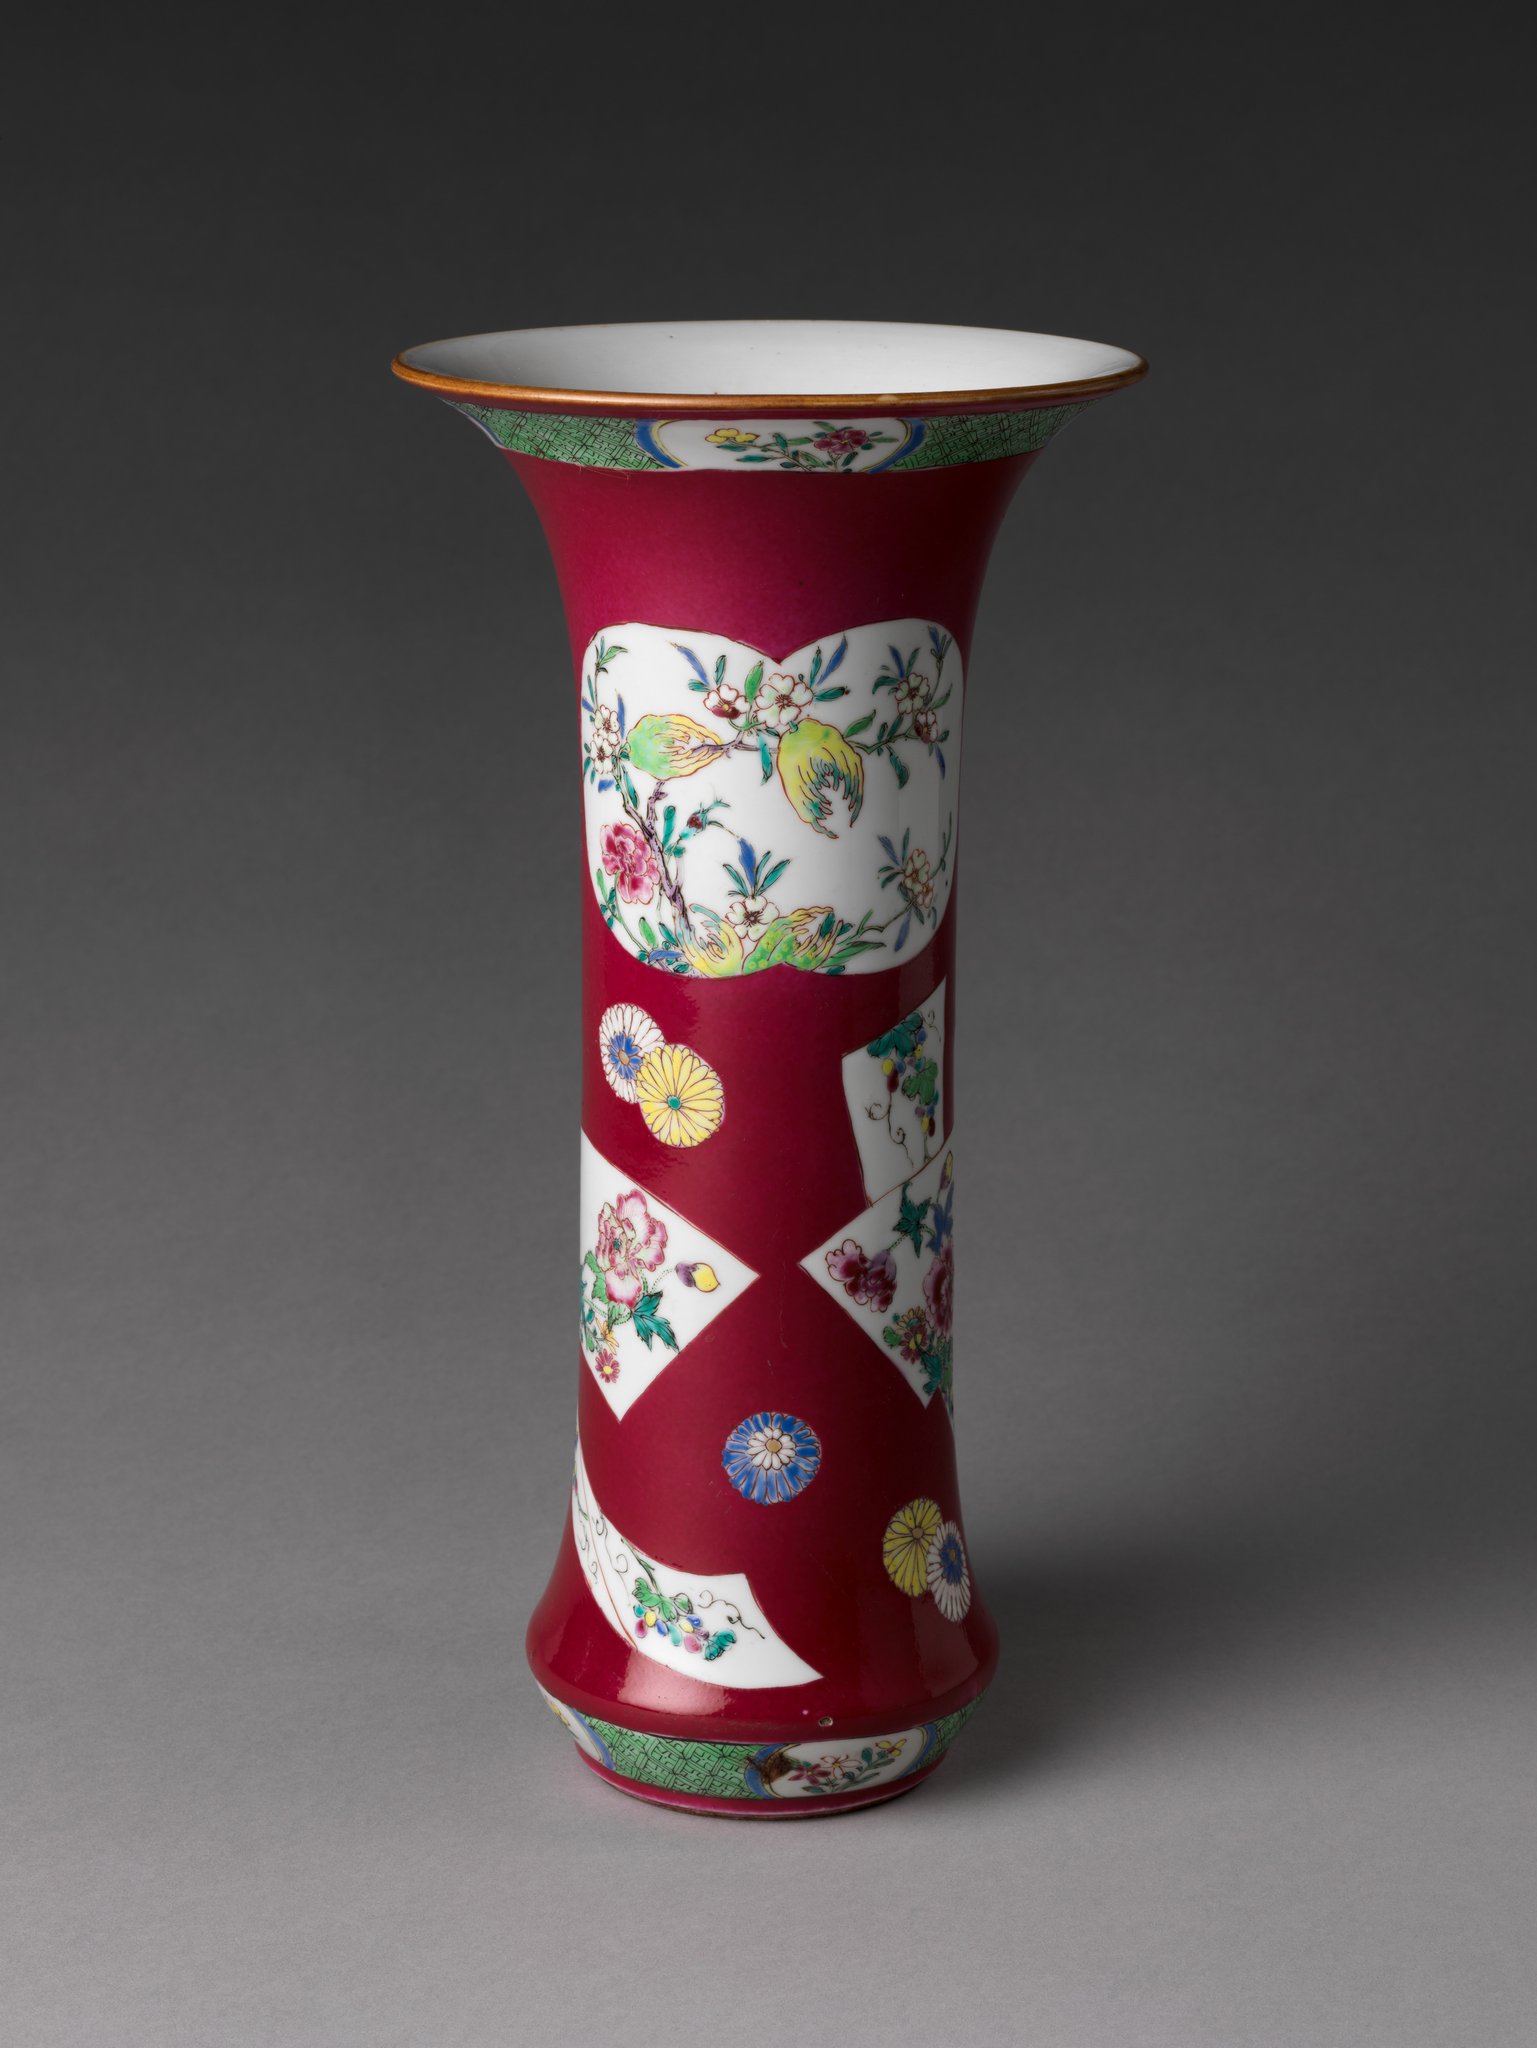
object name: vase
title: Vase with Flowers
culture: chinese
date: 1734-1766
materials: enamel, glaze, porcelain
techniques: painting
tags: flowers